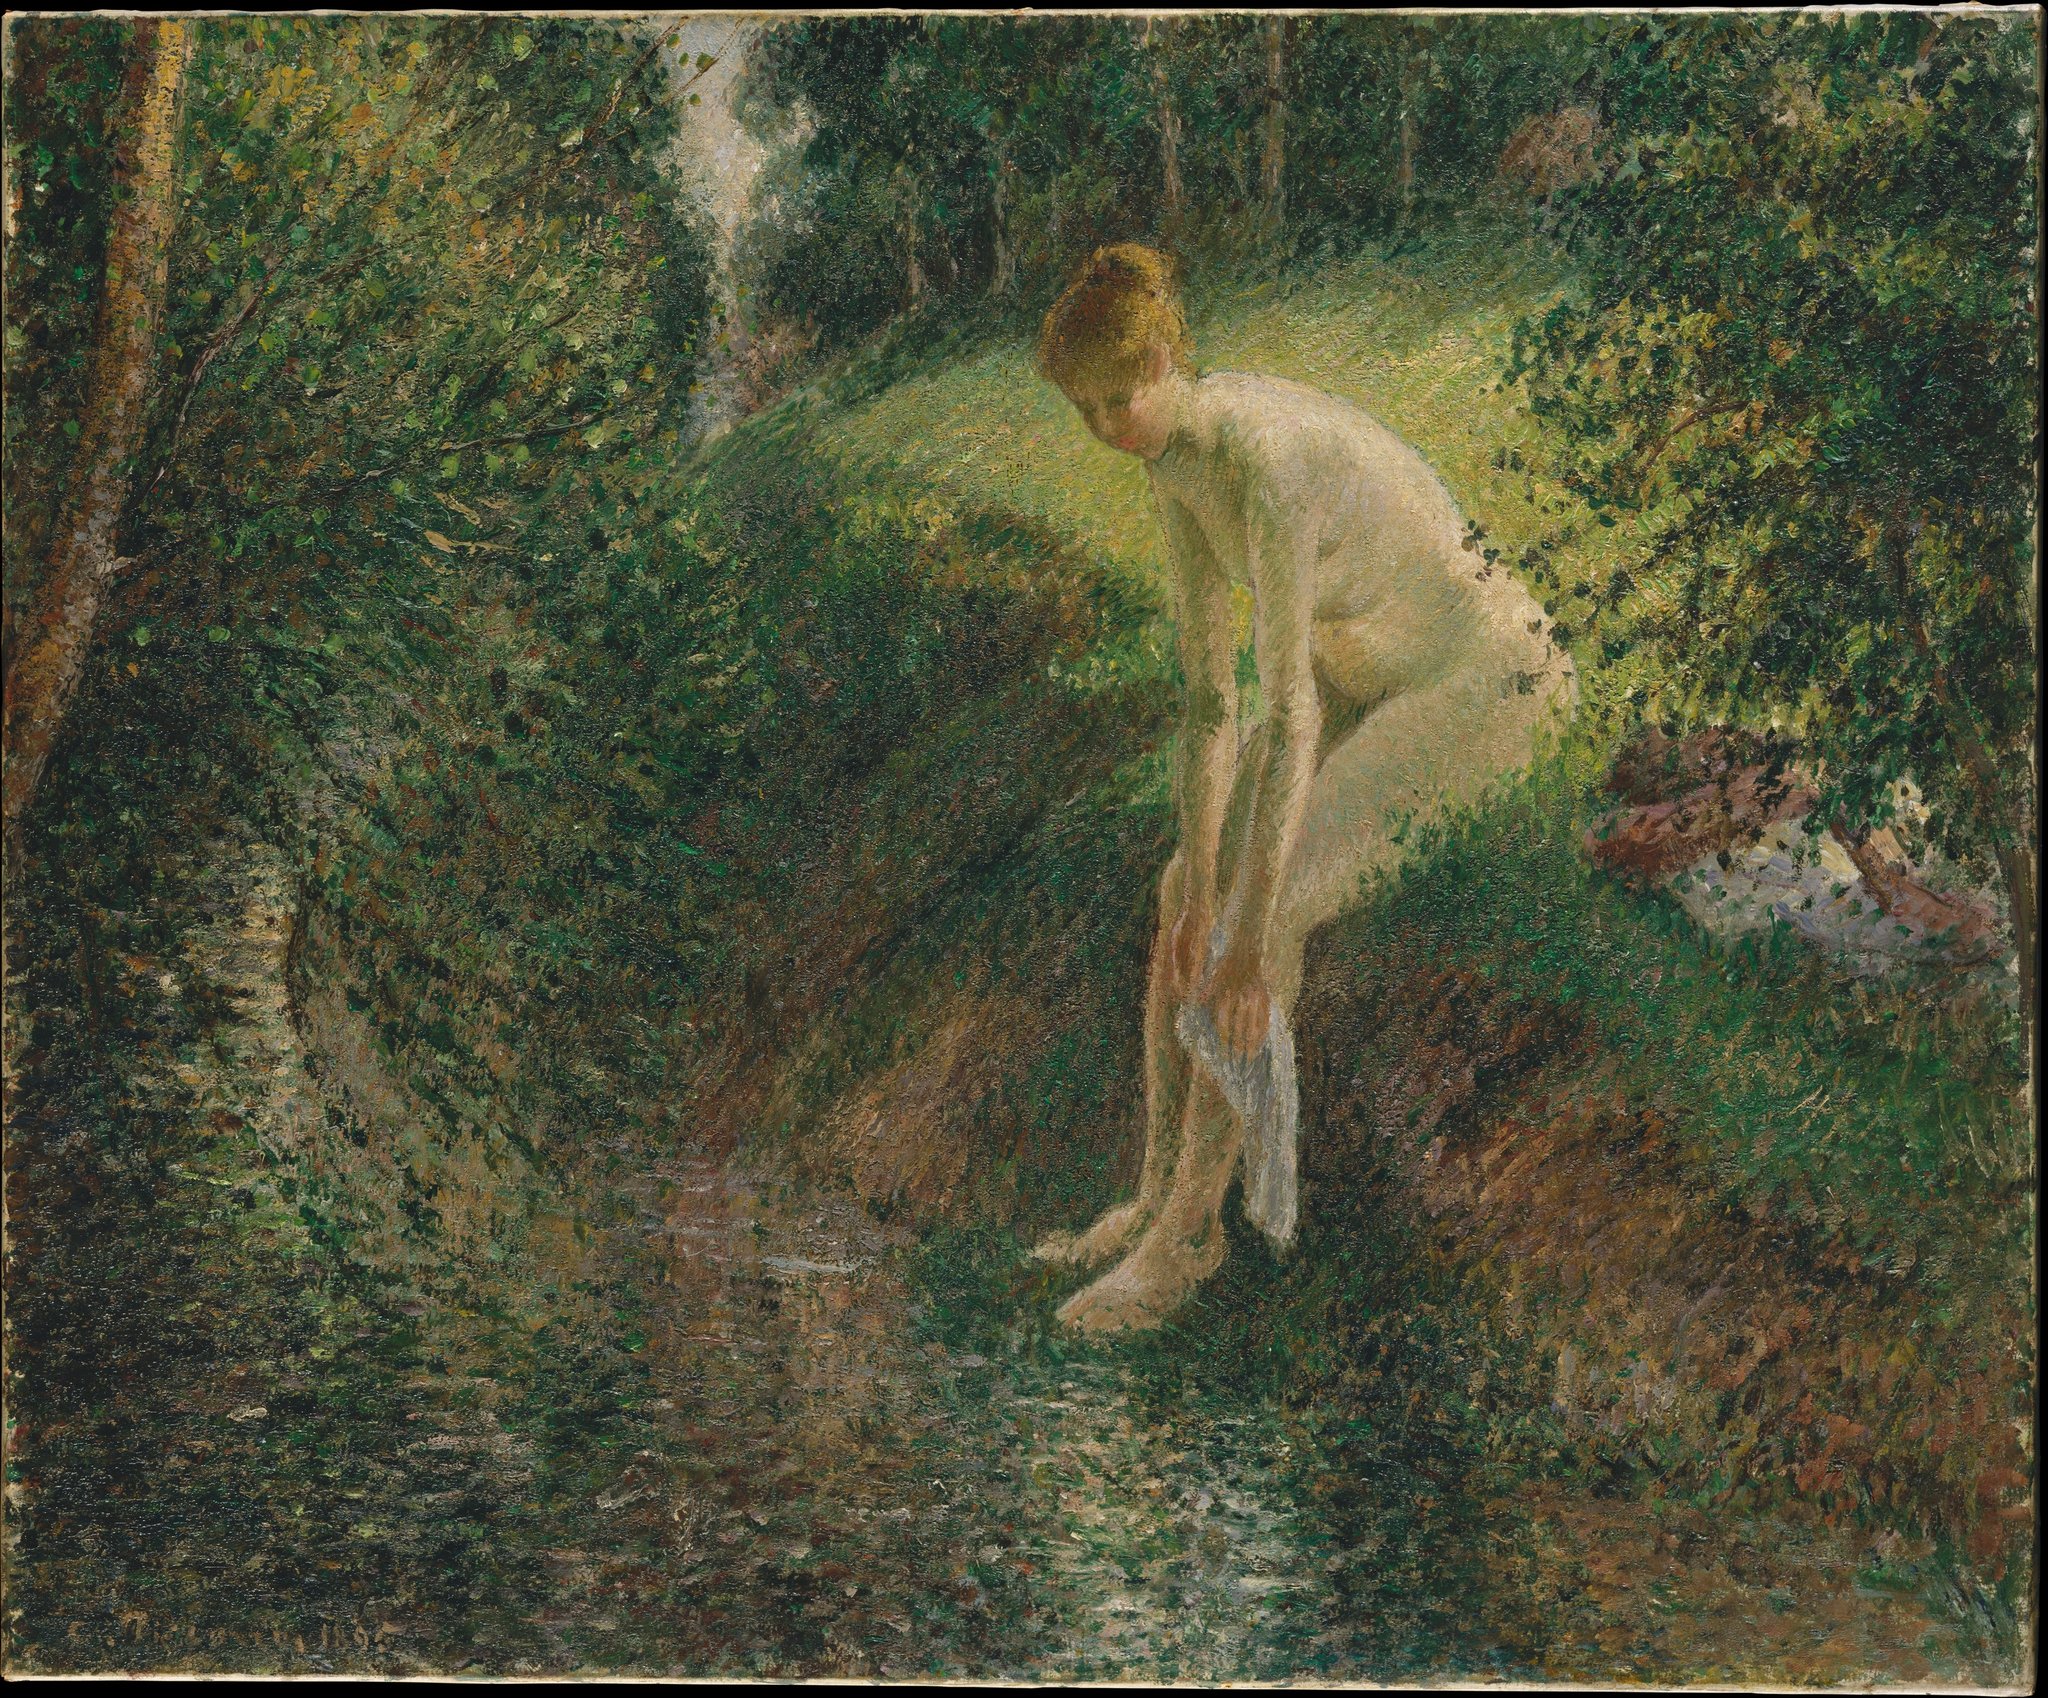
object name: painting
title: Bather in the Woods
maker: camille pissarro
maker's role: artist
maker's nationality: french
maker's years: 1830-1903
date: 1895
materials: canvas, oil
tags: female nudes,bathing